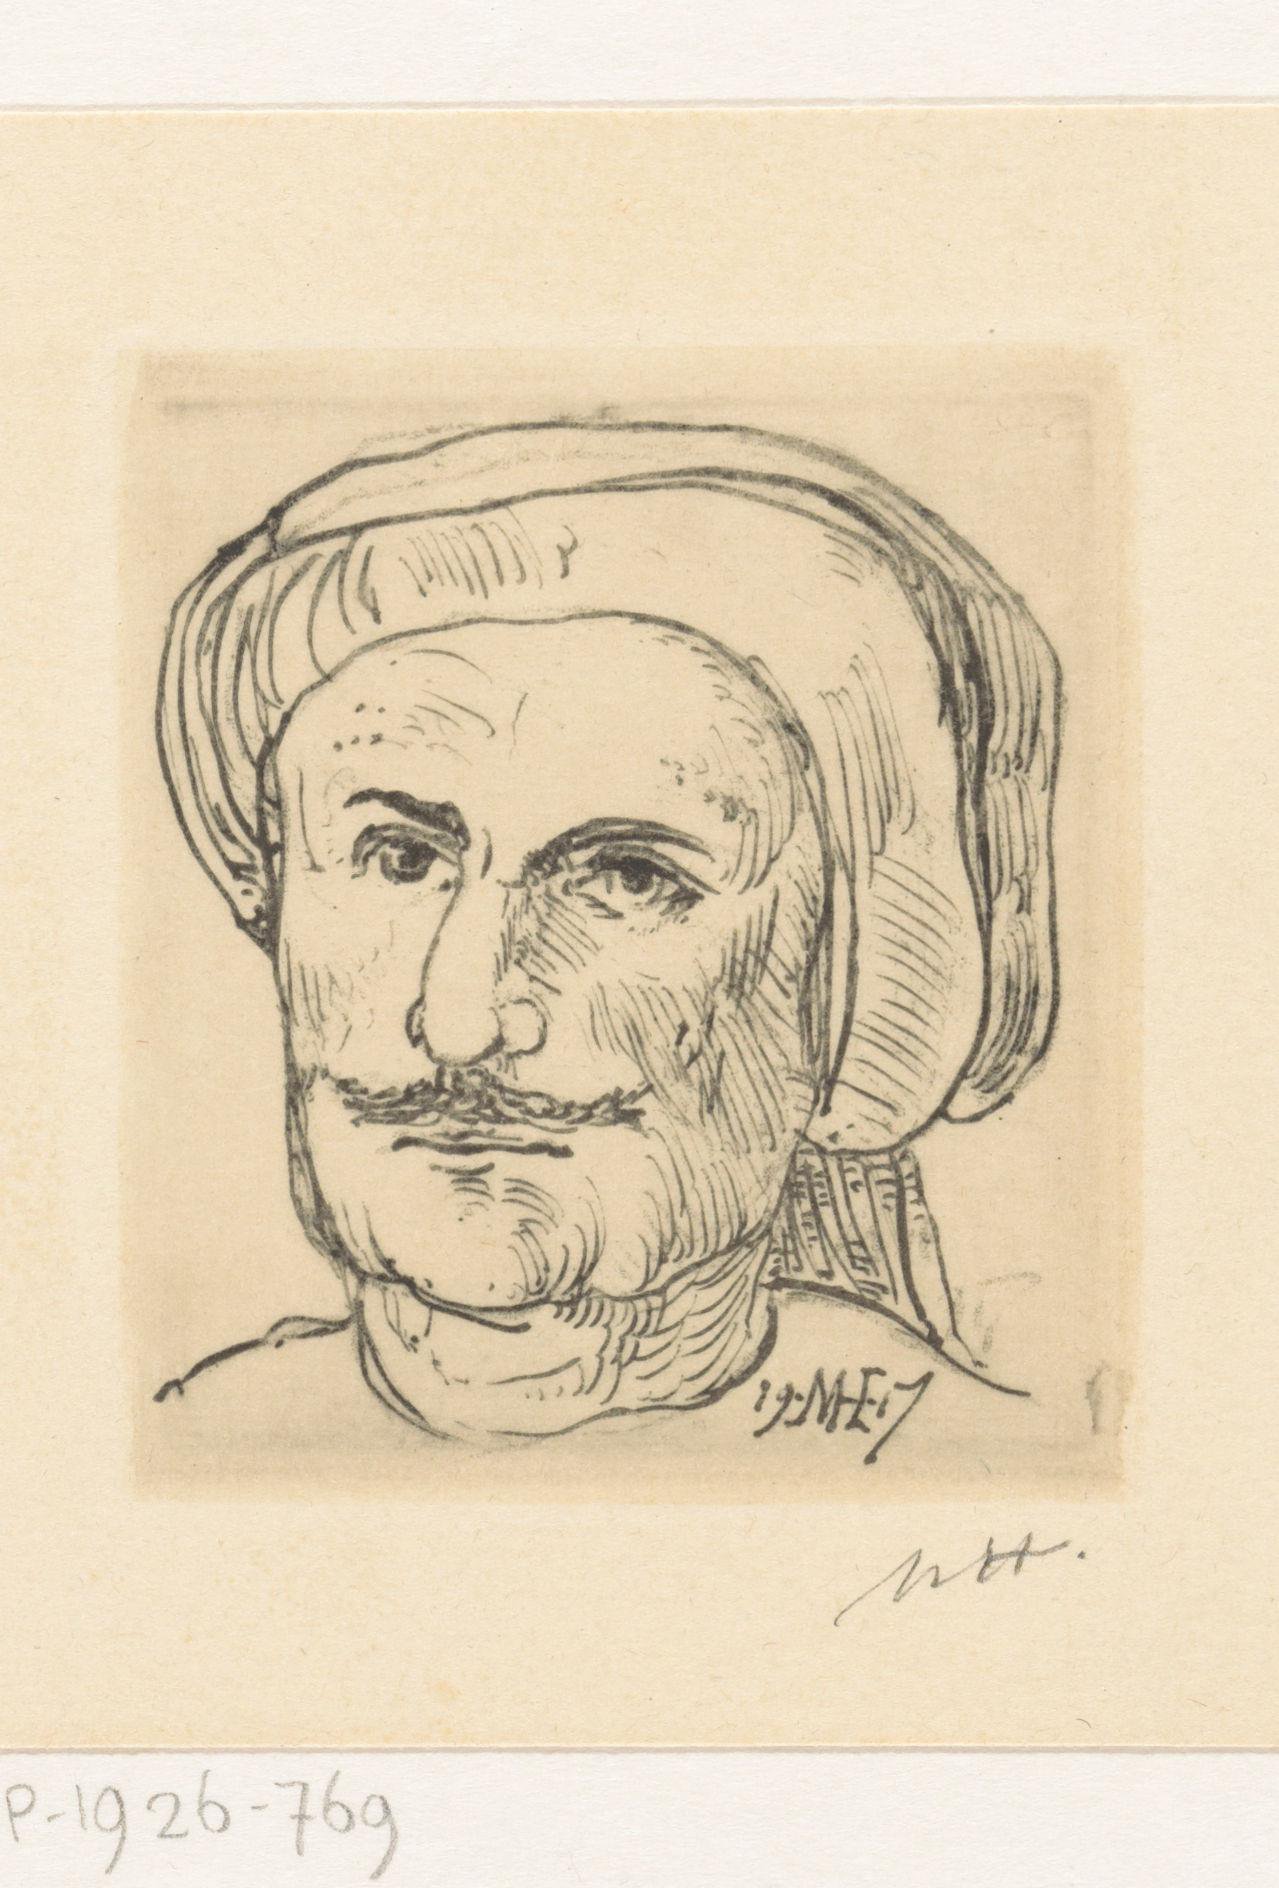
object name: print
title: Man met hoed en snor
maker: marius holleman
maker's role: draughtsman, print maker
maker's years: 1878-1926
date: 1917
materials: paper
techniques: etching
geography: groningen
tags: moustache, head-gear: hat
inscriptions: collector's mark: Lugt 2228